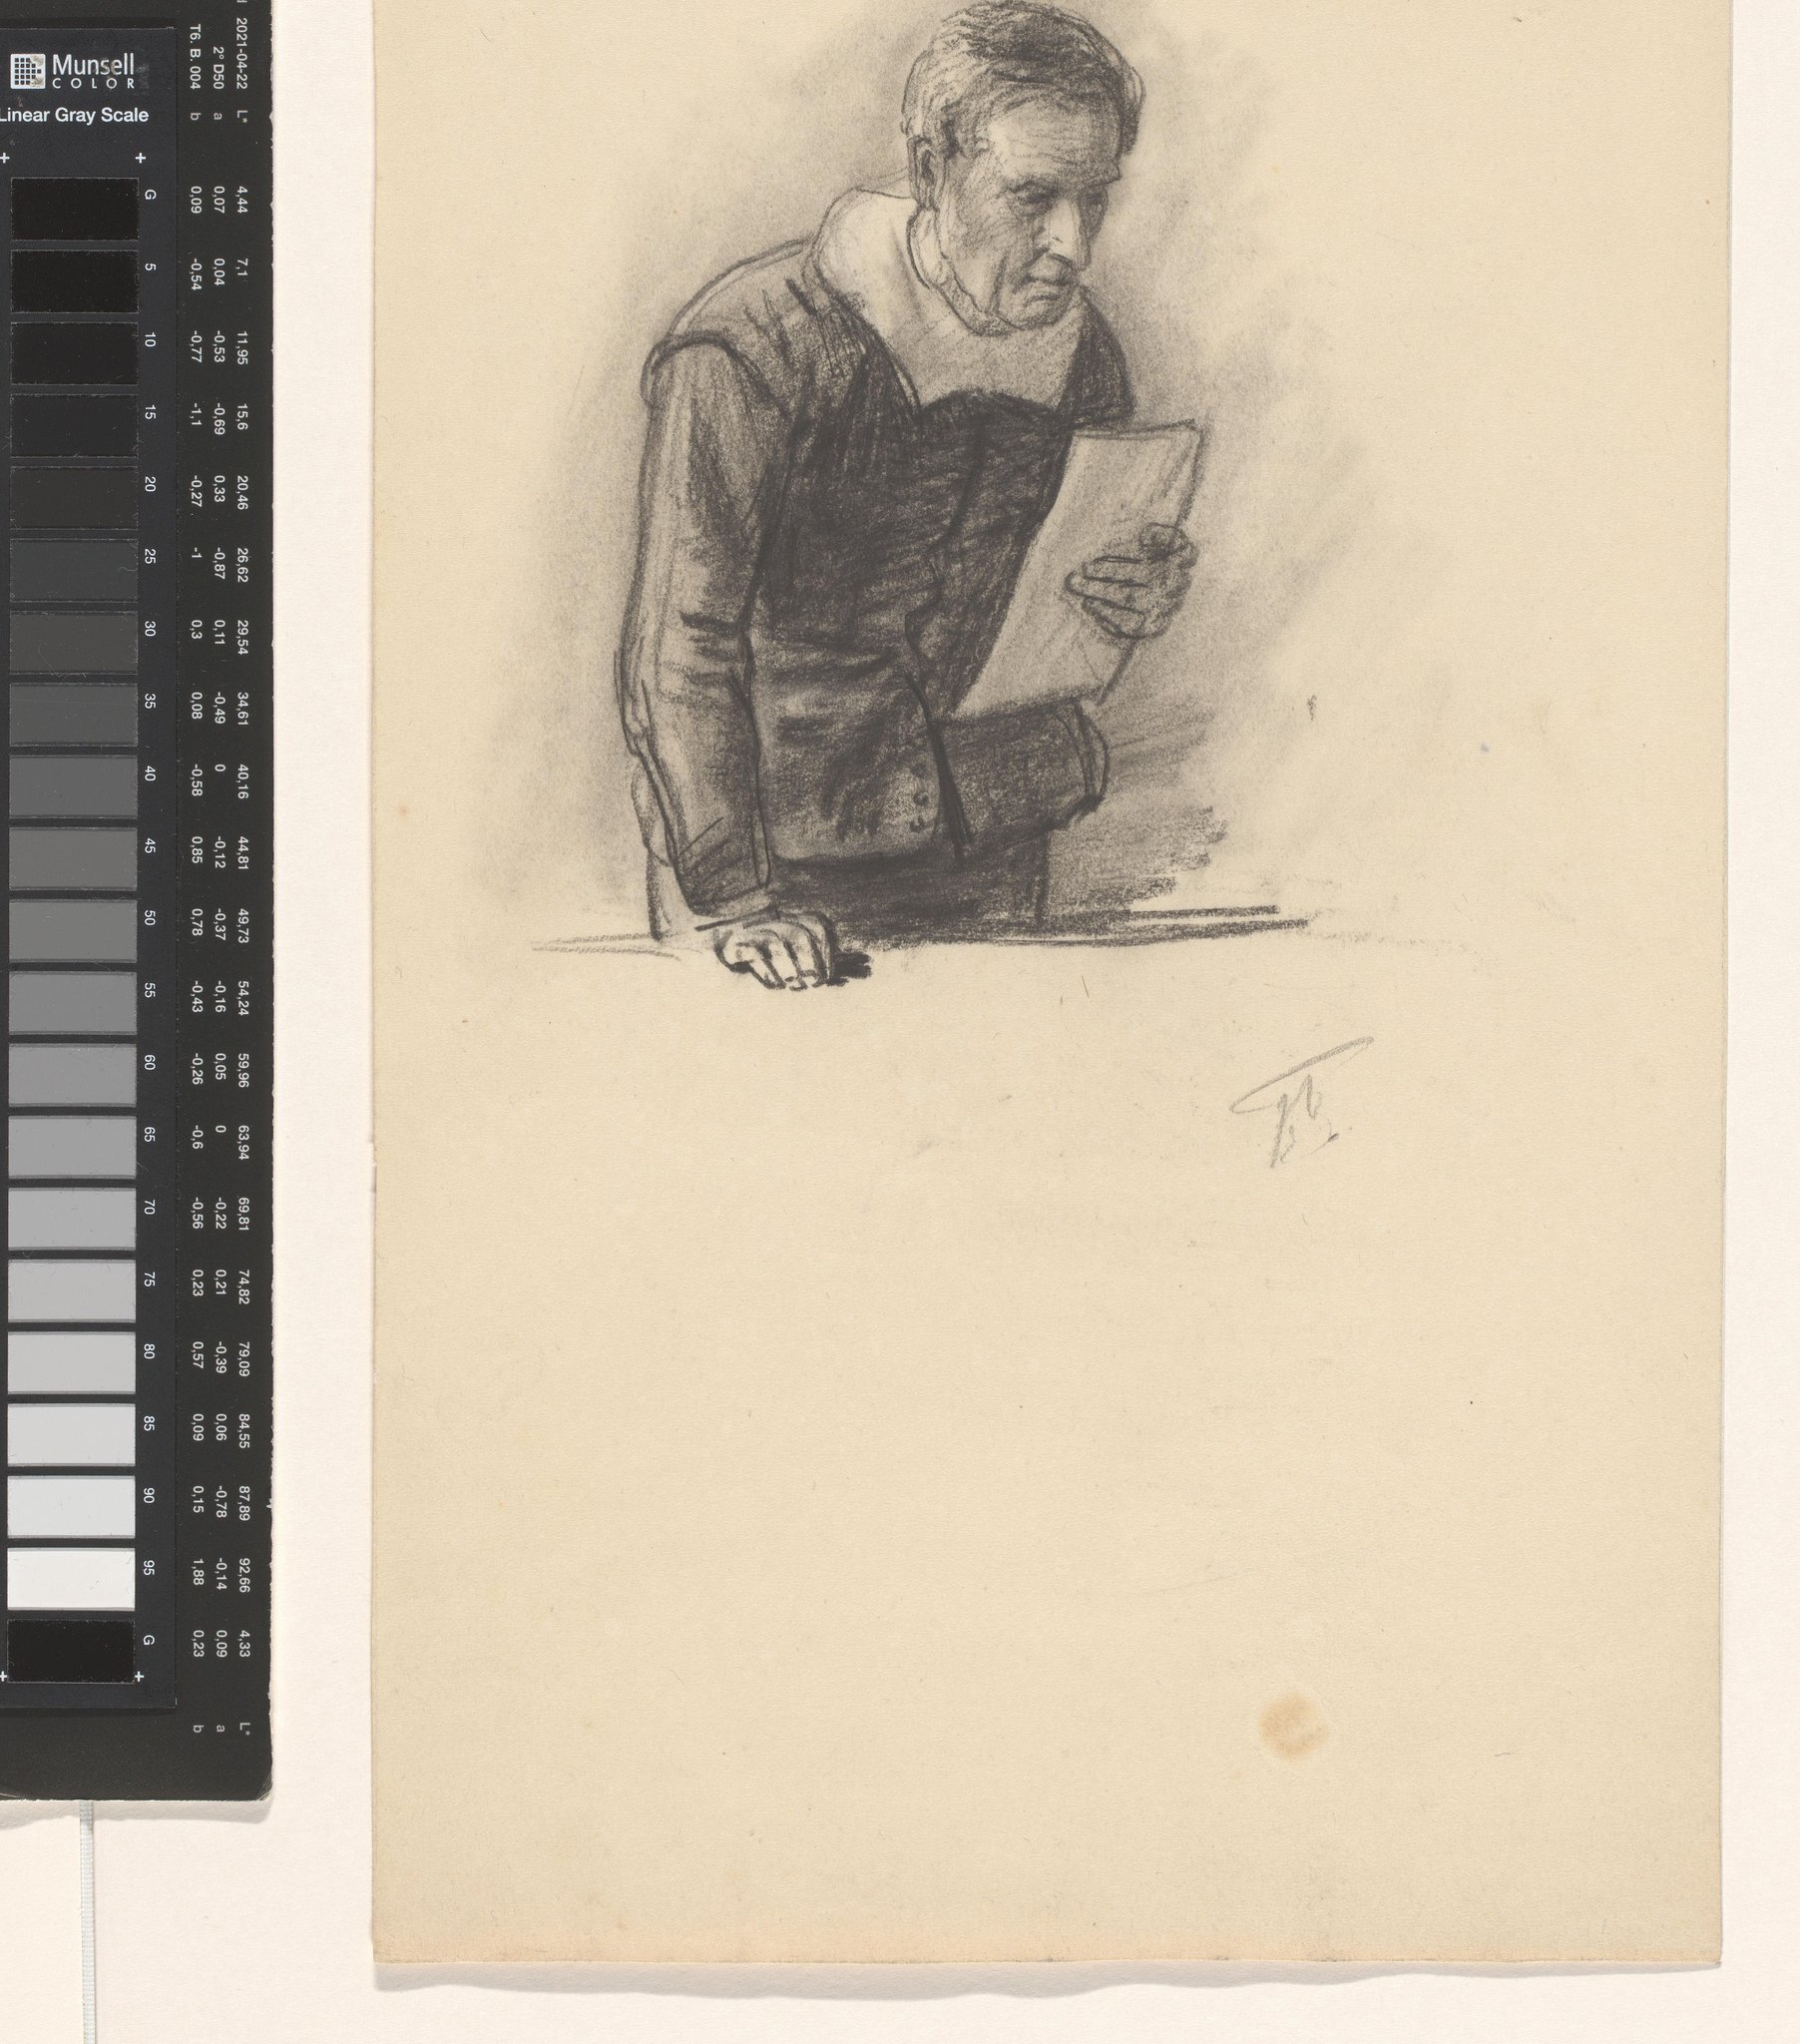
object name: drawing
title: Figuurstudie van een man in antikiserende kledij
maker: jacob taanman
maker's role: draughtsman, print maker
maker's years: 1836-1923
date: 1886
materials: chalk, paper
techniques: drawing, stumping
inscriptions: monogram: ‘J.T’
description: Staande man in antikiserende kledij, vanaf de heup weergegeven, staat aan een tafel met in zijn linker hand een vel papier.